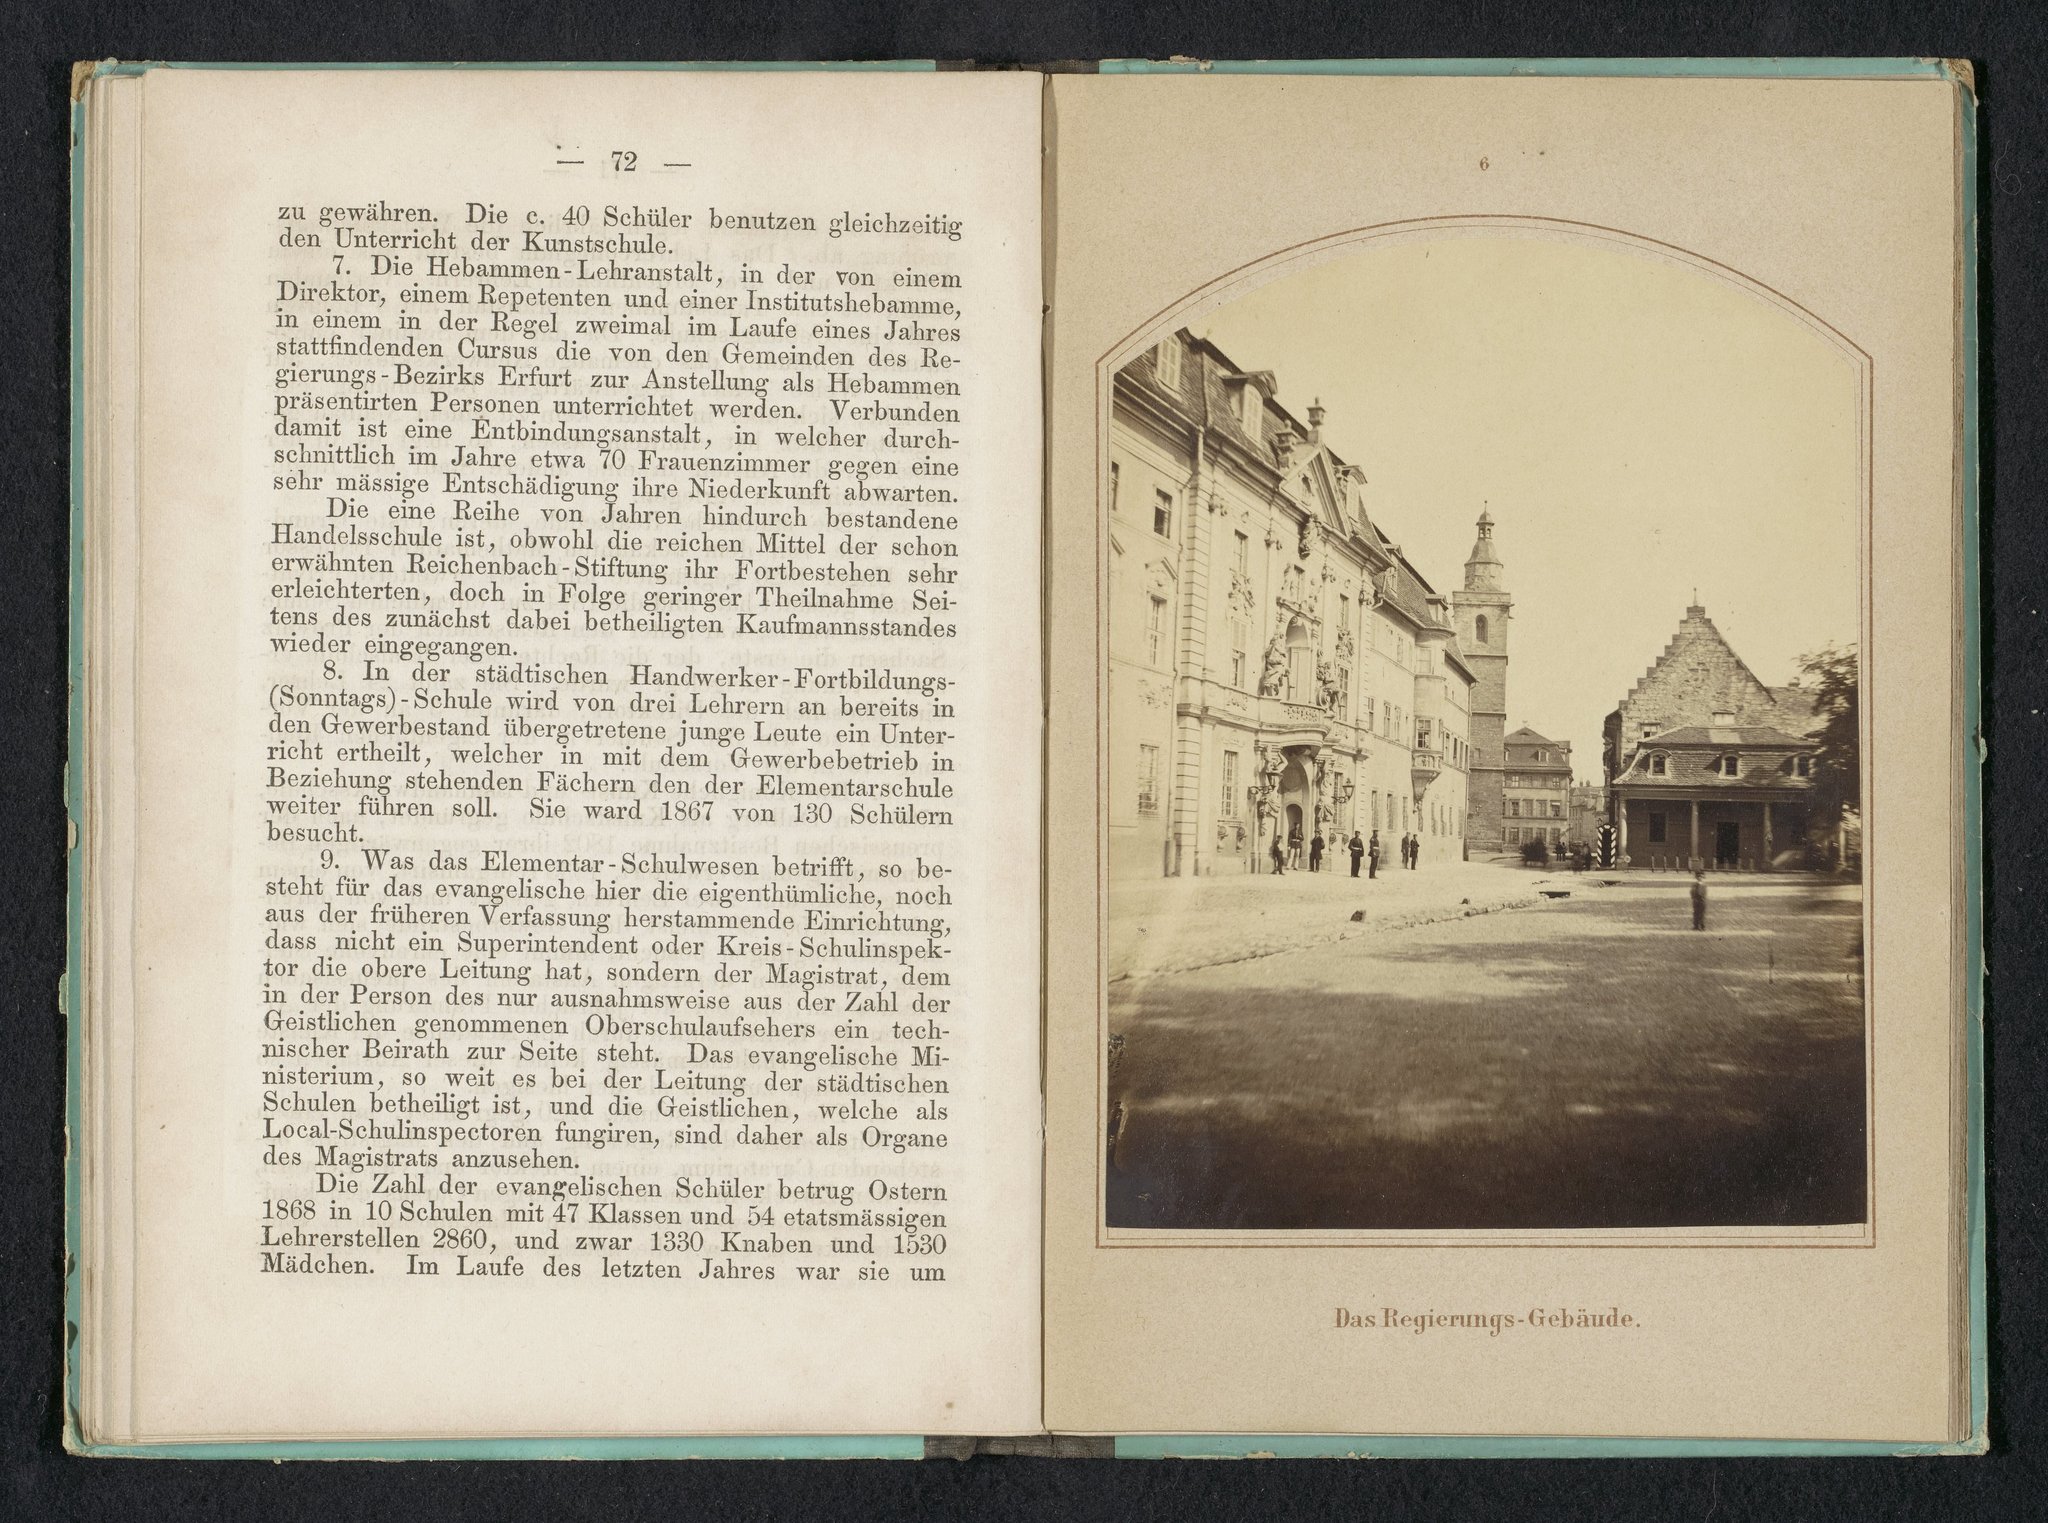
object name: photograph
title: Gezicht op de Thüringer Staatskanzlei te Erfurt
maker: Anonymous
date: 1858-1868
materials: photographic support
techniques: albumen print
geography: erfurt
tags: square, place, circus, etc., façade (of house or building)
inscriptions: number: ‘6’